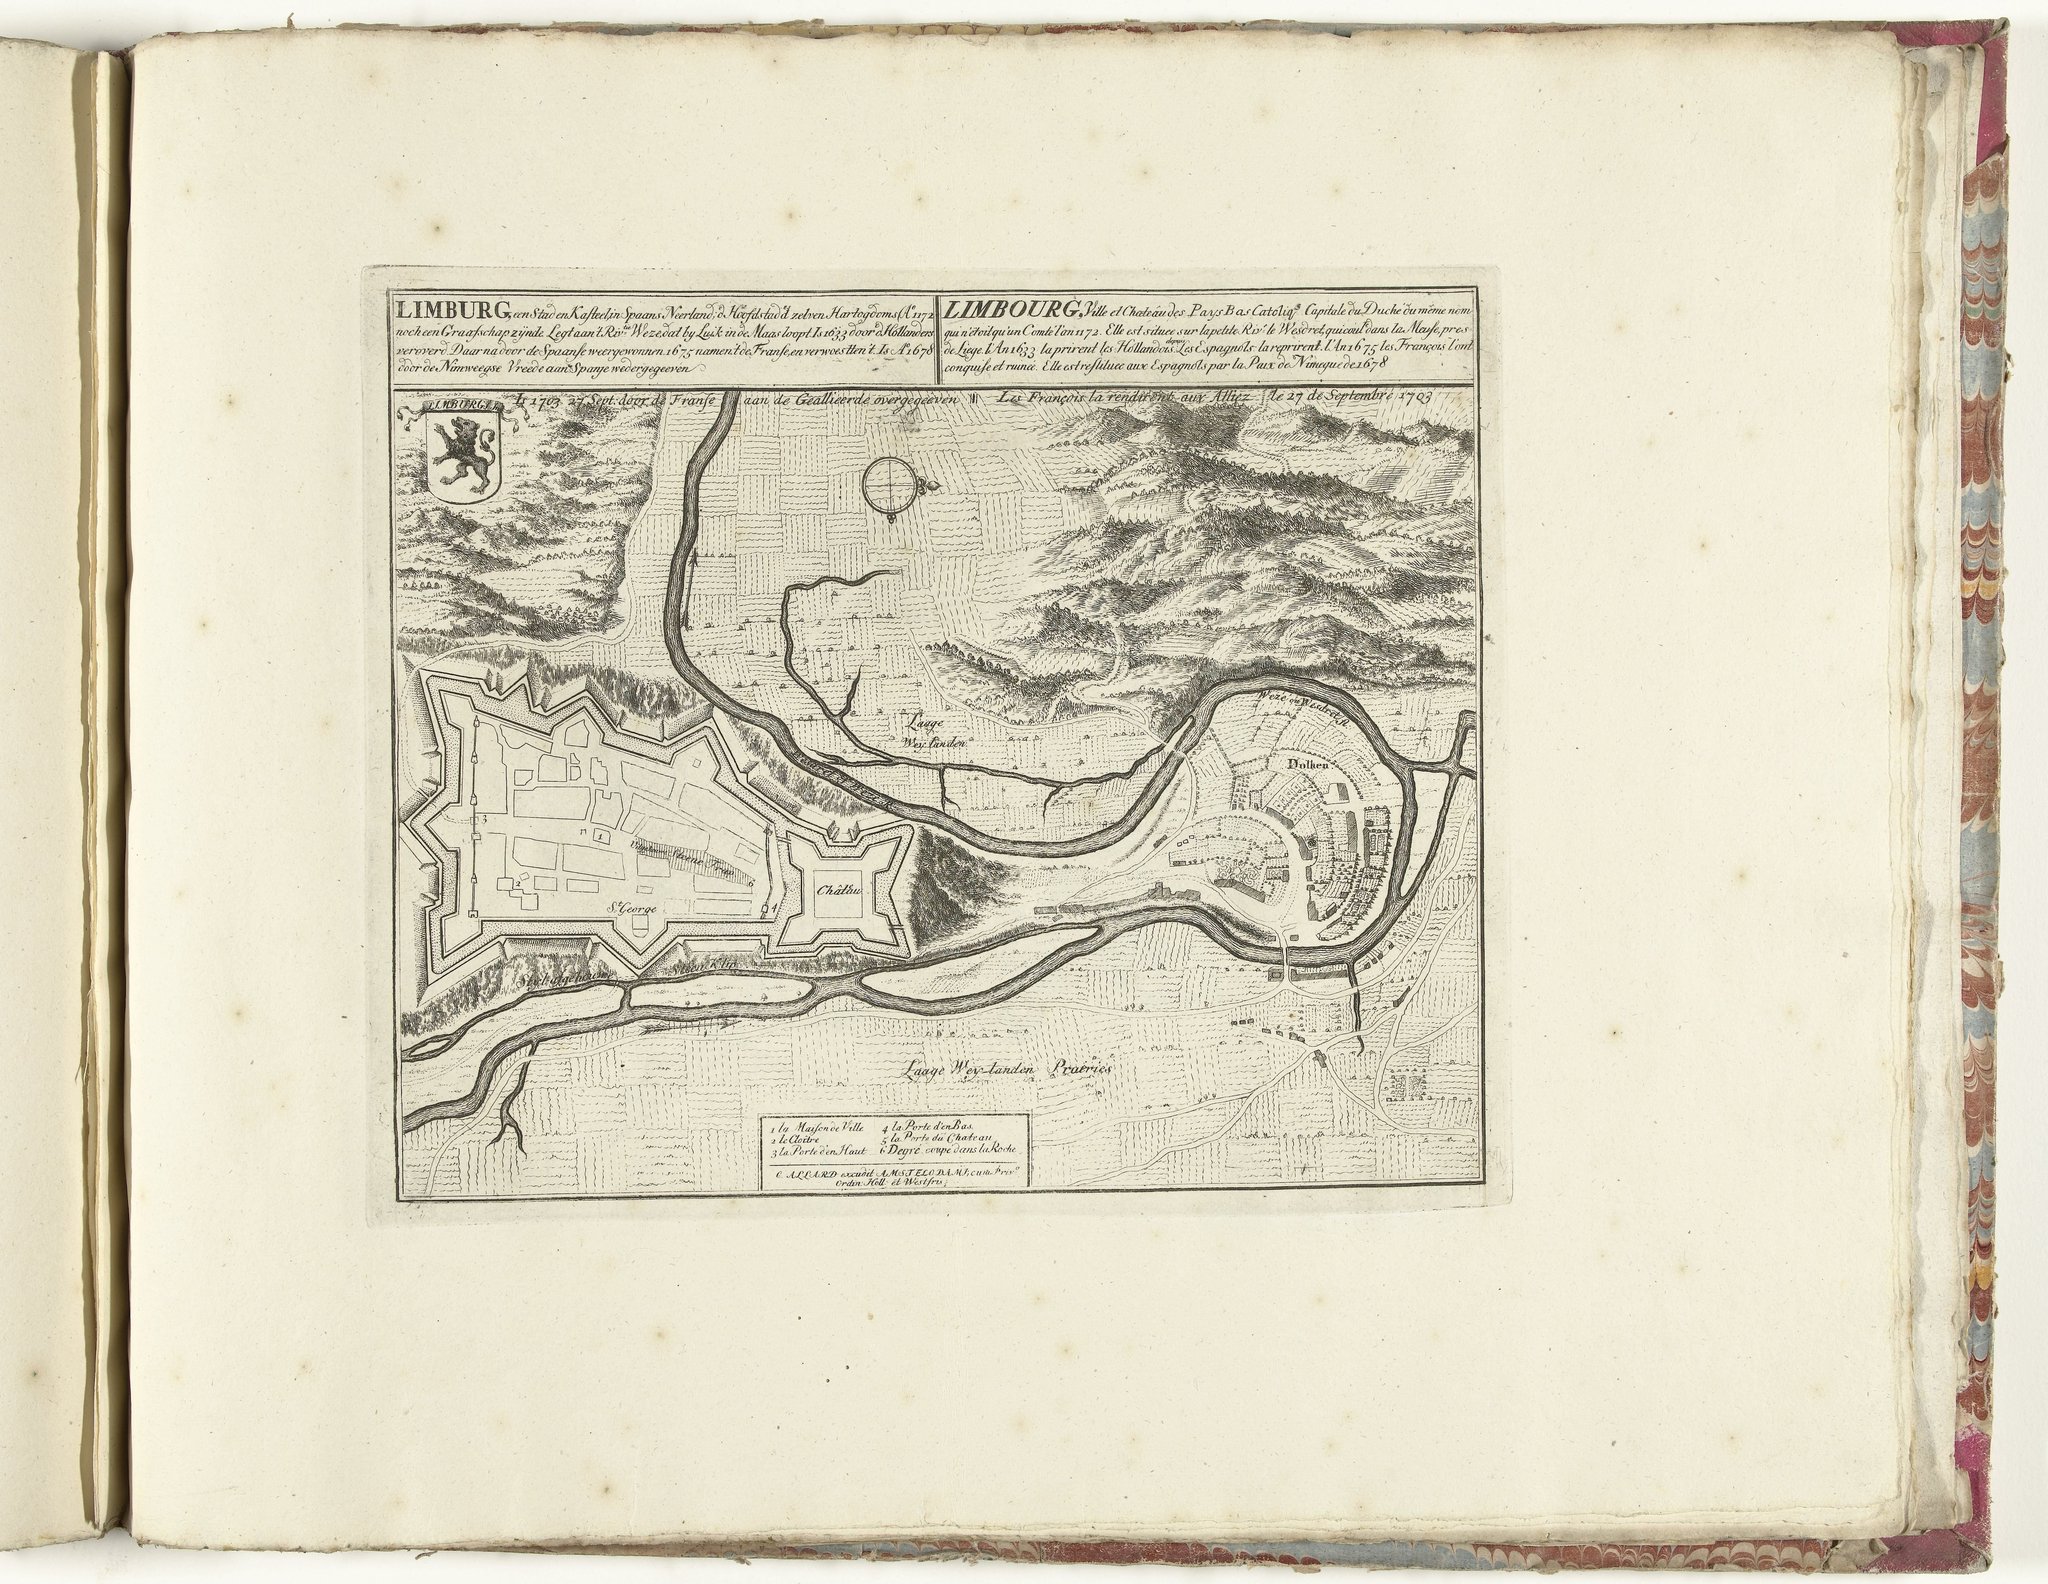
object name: album leaf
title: Plattegrond van Limburg, ca. 1701-1713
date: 1703-1714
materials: paper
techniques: etching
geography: france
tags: maps of cities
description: Gekopieerd naar de Franse prenten in: Nicolas de Fer, Les forces de l'Europe, ou description des principales villes, avec leurs fortifications : dessignées par les meilleurs ingenieurs, particulierement celles ... de la France, dont les plans ont esté levez par M. de Vauban, Nicolas de Fer, Parijs 1693-1696, of andere voorbeelden.